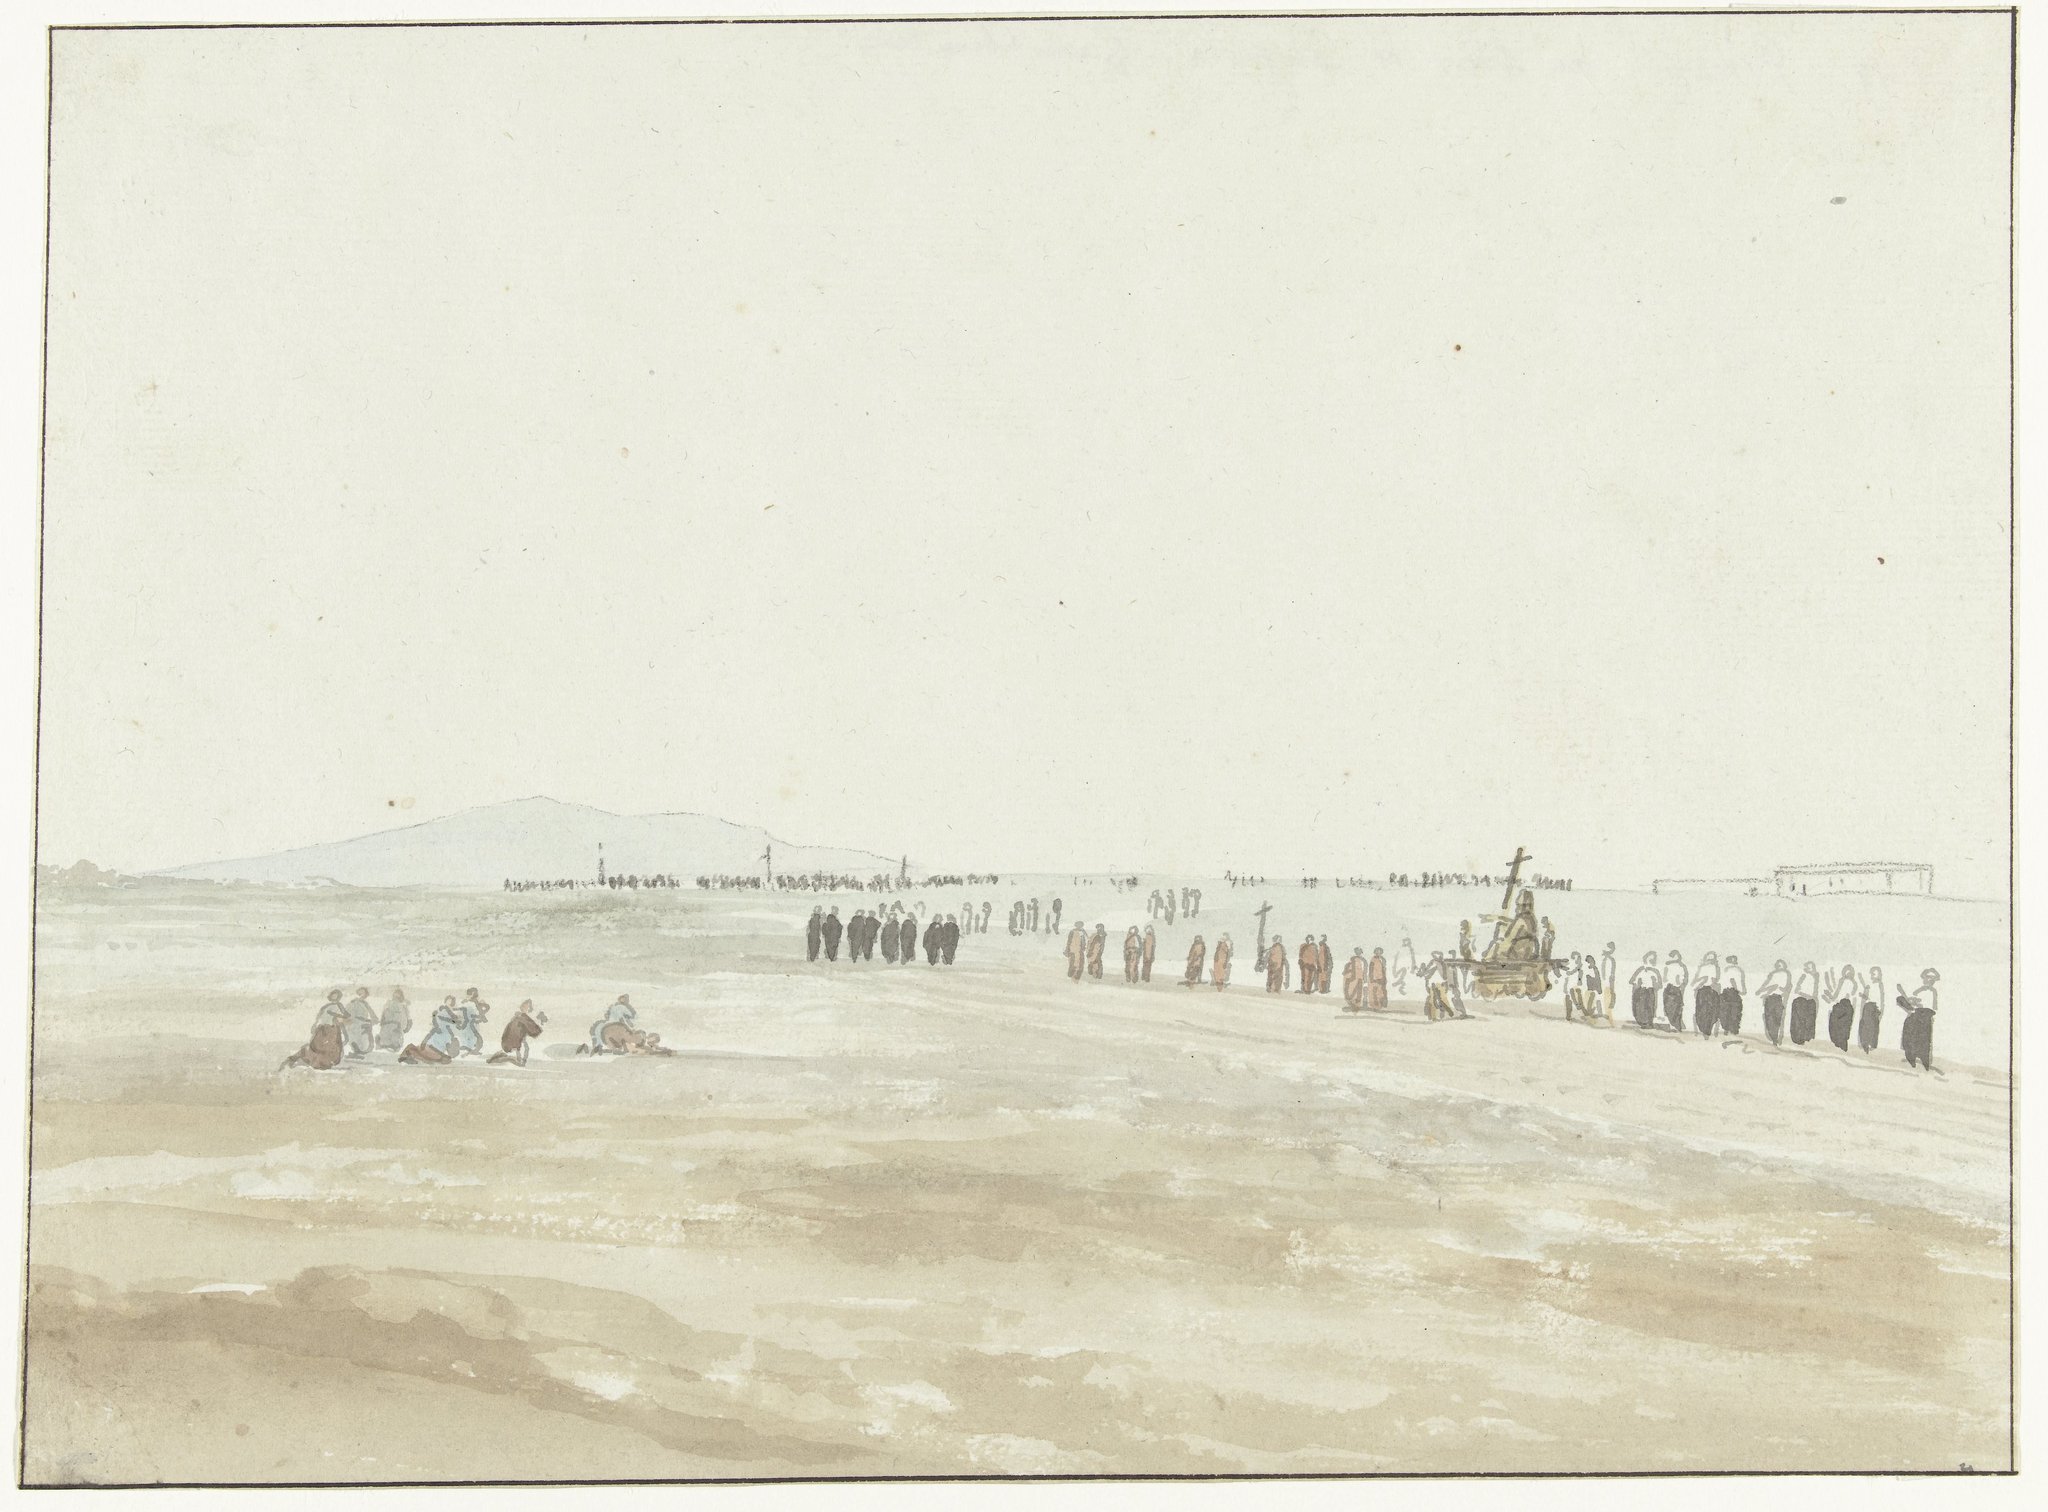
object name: drawing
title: Processie in de omgeving van Cerignola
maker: louis ducros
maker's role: draughtsman, print maker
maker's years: 1748-1810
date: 1778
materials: paper, watercolor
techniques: brush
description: Tekening uit het album 'Voyage en Italie, en Sicile et à Malte', 1778.